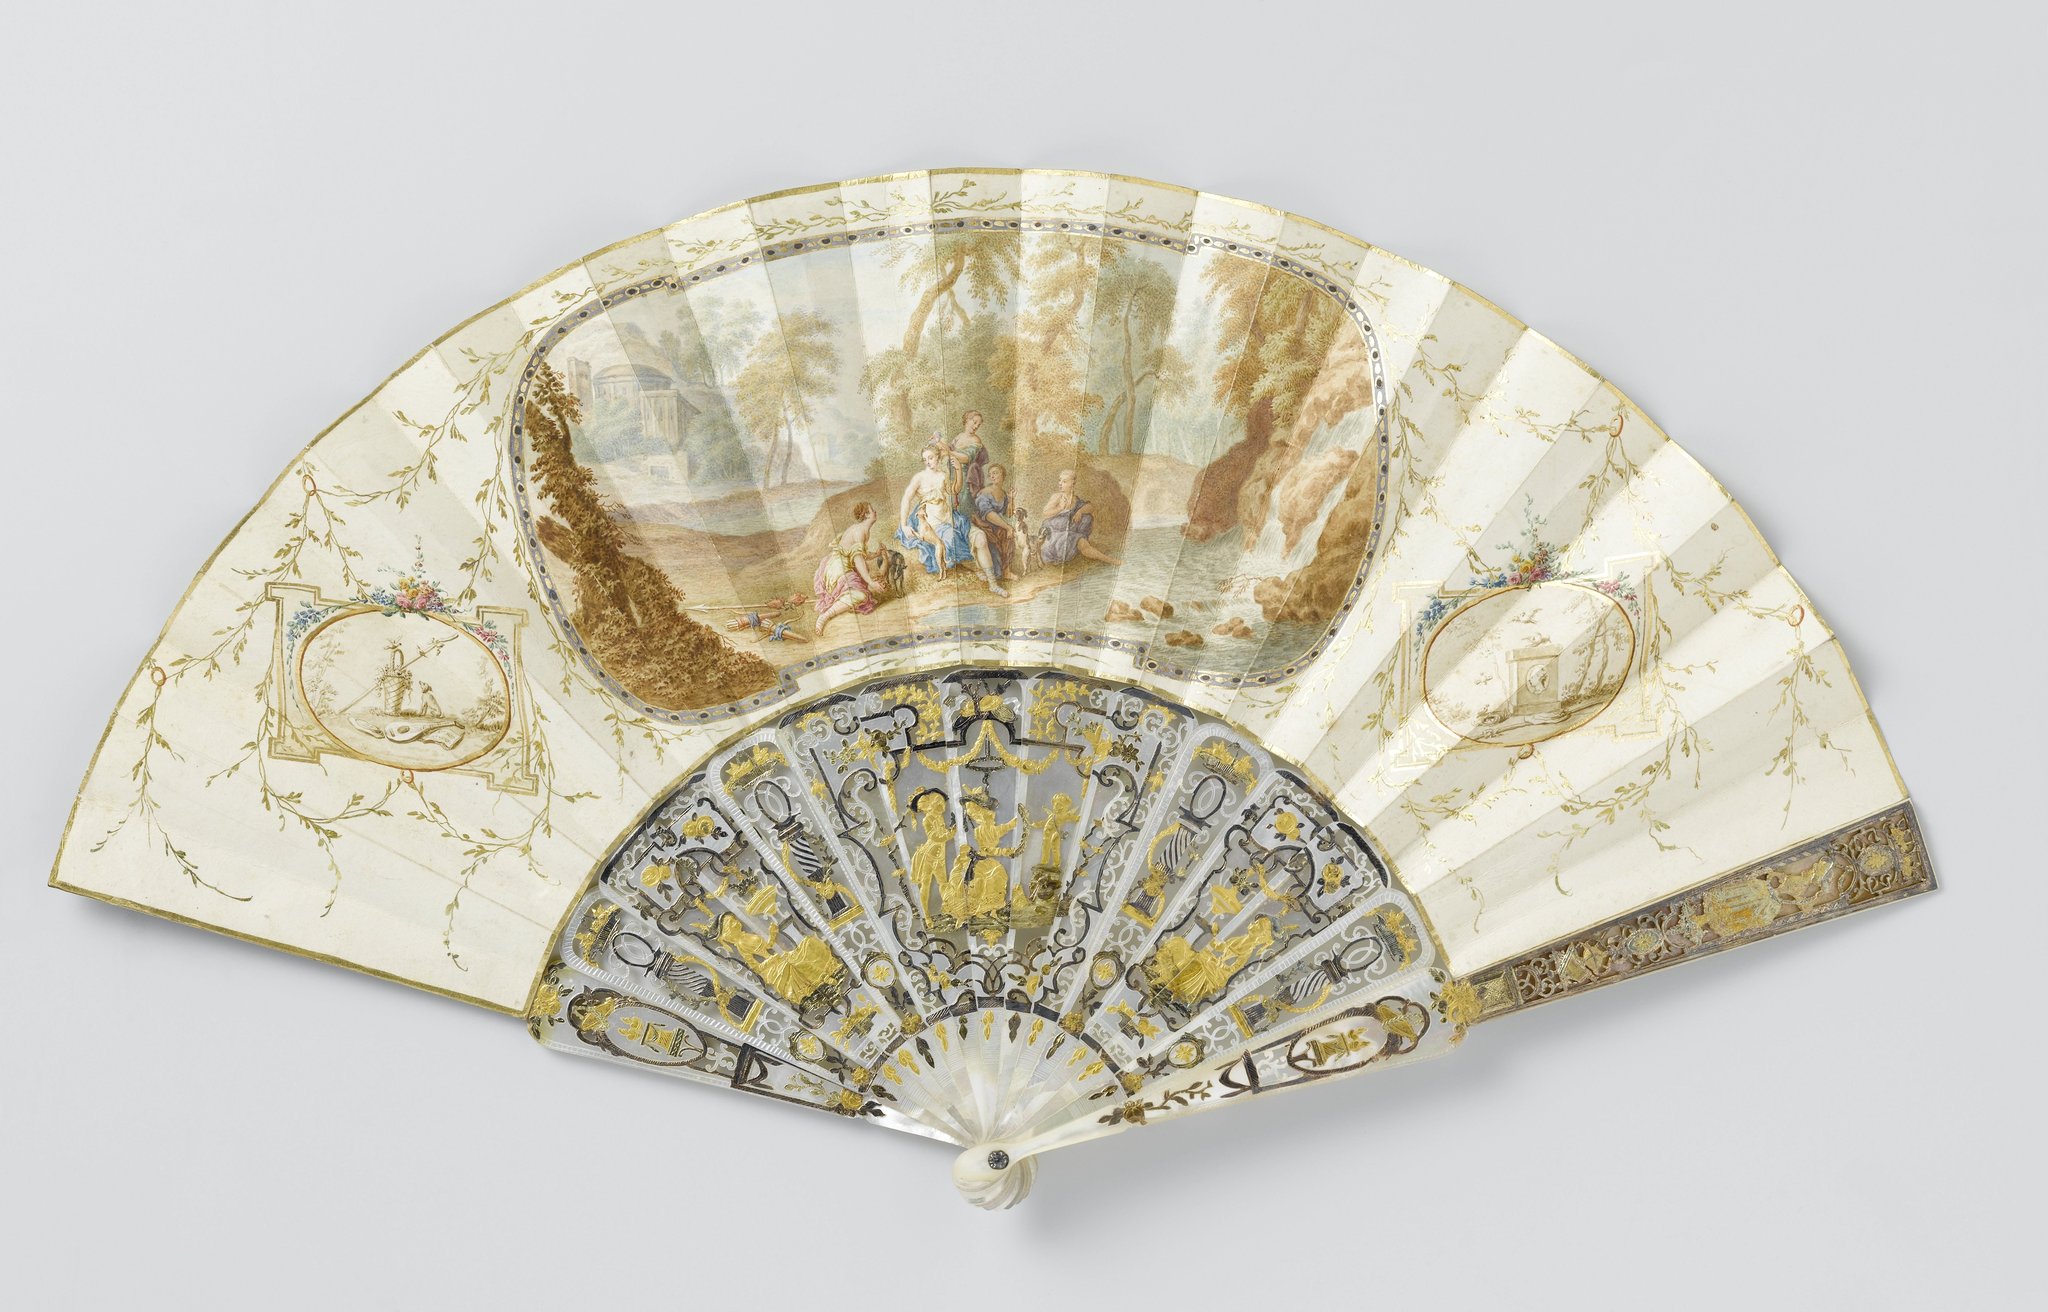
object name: vouwwaaier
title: Vouwwaaier met een blad van papier waarop in aquarel een centraal medaillon met Diana en haar nimfen rustend bij een rivier, gemonteerd op een montuur van ajour en in reliëf gesneden ivoor met 'métal en quatre couleurs'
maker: Anonymous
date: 1780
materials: cardboard, gold leaf, mother of pearl, paper, paste, watercolor, wood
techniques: cutting, grinding, painted, printing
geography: netherlands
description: Het centrale medaillon is gevuld met een bijzonder gedetailleerde schildering van Diana, godin van de jacht, die met haar nimfen rust aan de rand van een rivier tegenover een waterval. In Nederland was 'Diana rustend met haar nimfen' al vanaf de 17de eeuw een bijzonder geliefd thema, dat niet alleen veelvuldig op schilderijen maar ook op waaierbladen werd afgebeeld (vgl. tent.cat. C. Kammerl, Der Fächer..., München 1989, cat.nr.53, p.139). Dit is niet verwonderlijk, aangezien Artemis de kuisheid van de vrouw symboliseerde en op deze waaier als zodanig is gekoppeld aan de huwelijkse liefde. De medaillons aan weerszijden staan in het teken van de (pastorale) liefde, met links een herdersstaf, mandje met bloemen, duifjes, hond de (huwelijks)trouw voorstellende, platte hoed en luit; en rechts een altaar met een vrouwenportret waarboven twee tortelduiven, een nestje gevuld met eitjes waarbij twee vogeltjes, herdersstaf en hoed. Het blad is aan de achterkant beschilderd met een met twee tortelduifjes gevuld medaillon, dat aan een bloemenslinger hangt. Ook in het montuur treffen we liefdessymboliek aan. Op het handdeel staat centraal een paar dat een bloemenkrans aan Eros offert. Boven hen hangt een gevlochten liefdeskrans of bruidskroon. Aan weerszijden van deze voorstelling zuiltjes met verstrengelde monogrammen(?) waarboven een bloemenmandje, geflankeerd door elkaar toegewende zittende vrouwen. De buitenbenen zijn van boven naar beneden versierd met een bloemenmandje, herderin(?) met guirlande in de hand, trofee met boeken(?) en op het handdeel met een huwelijksaltaar met twee brandende harten.